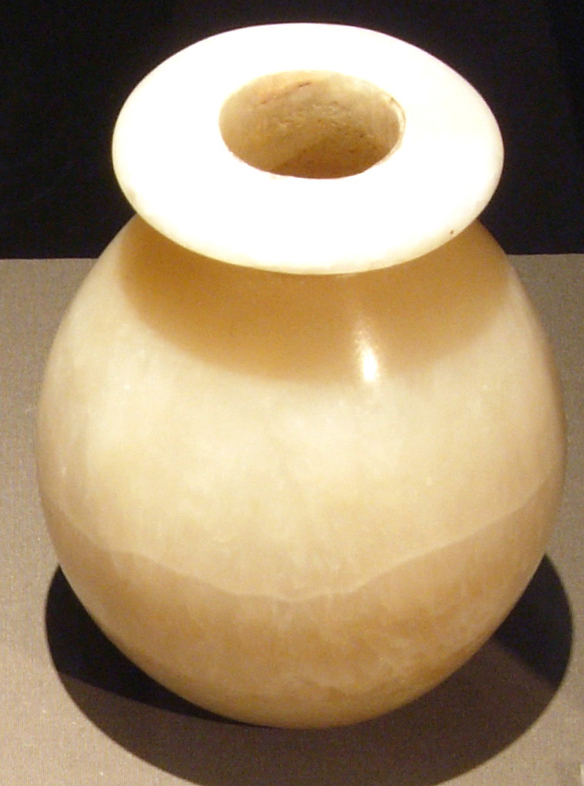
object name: bag shaped jar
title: Bag-shaped Jar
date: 1550-1450 BCE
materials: stone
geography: egypt